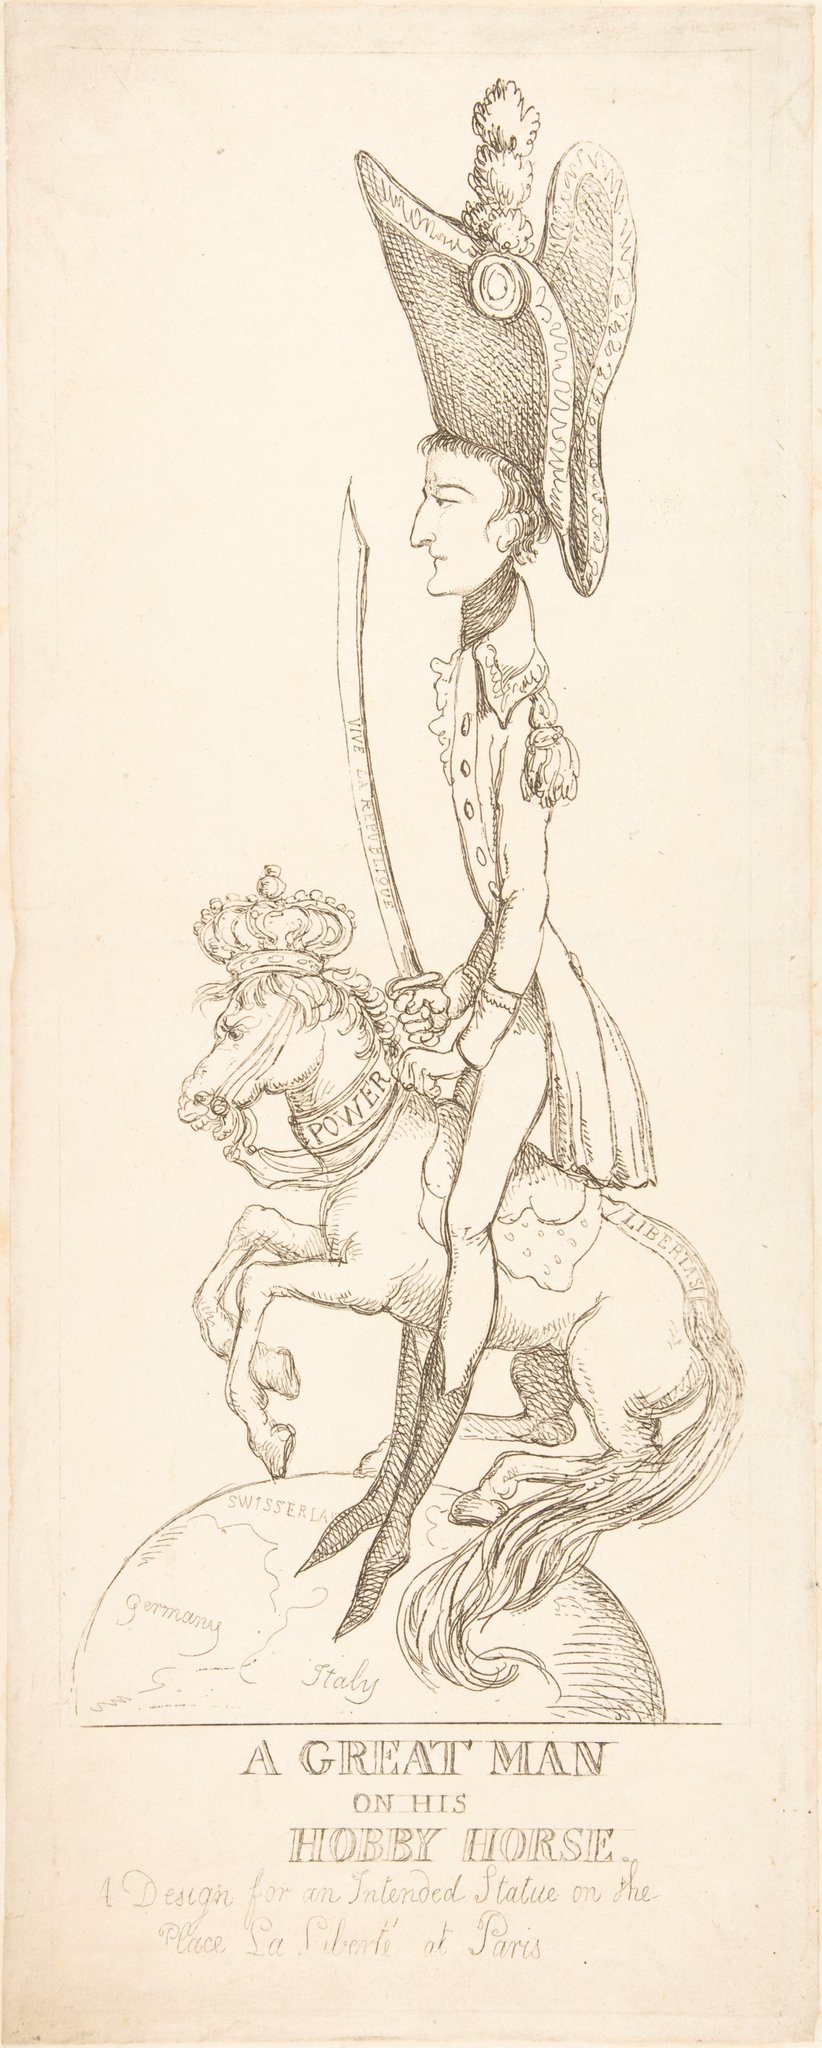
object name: print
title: A Great Man on His Hobby Horse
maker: thomas rowlandson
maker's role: artist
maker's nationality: british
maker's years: 1757-1827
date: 1803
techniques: etching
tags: satire,napoleon i,men,horses,politics